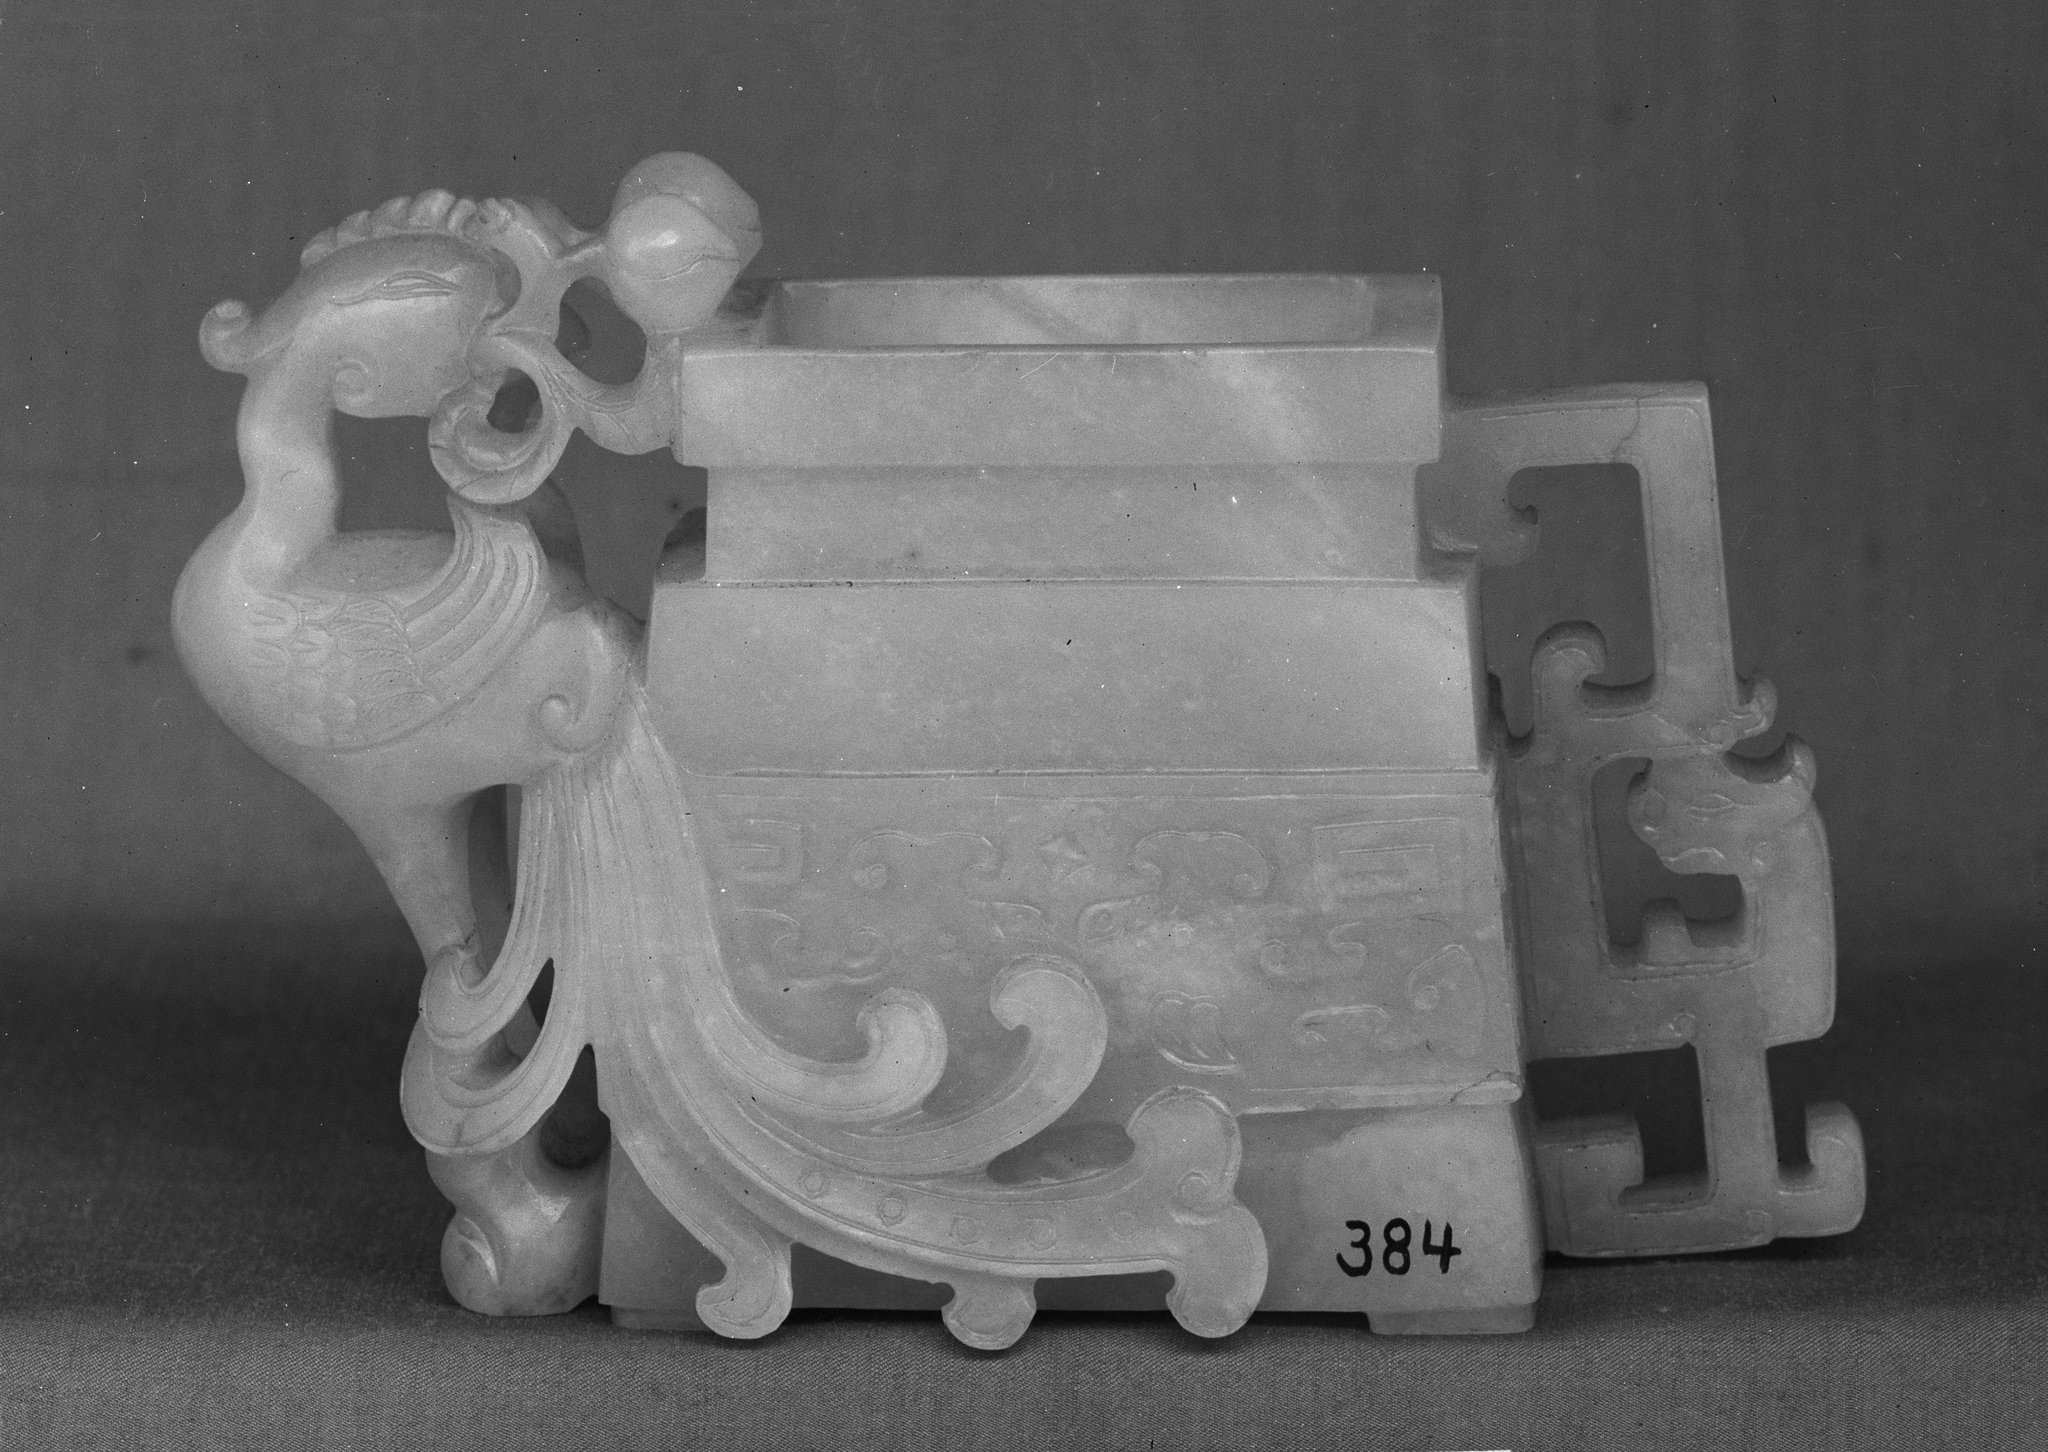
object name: vase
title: Rectangular Vase with Pheonix Perched on a Rock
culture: chinese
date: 1368-1644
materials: jade